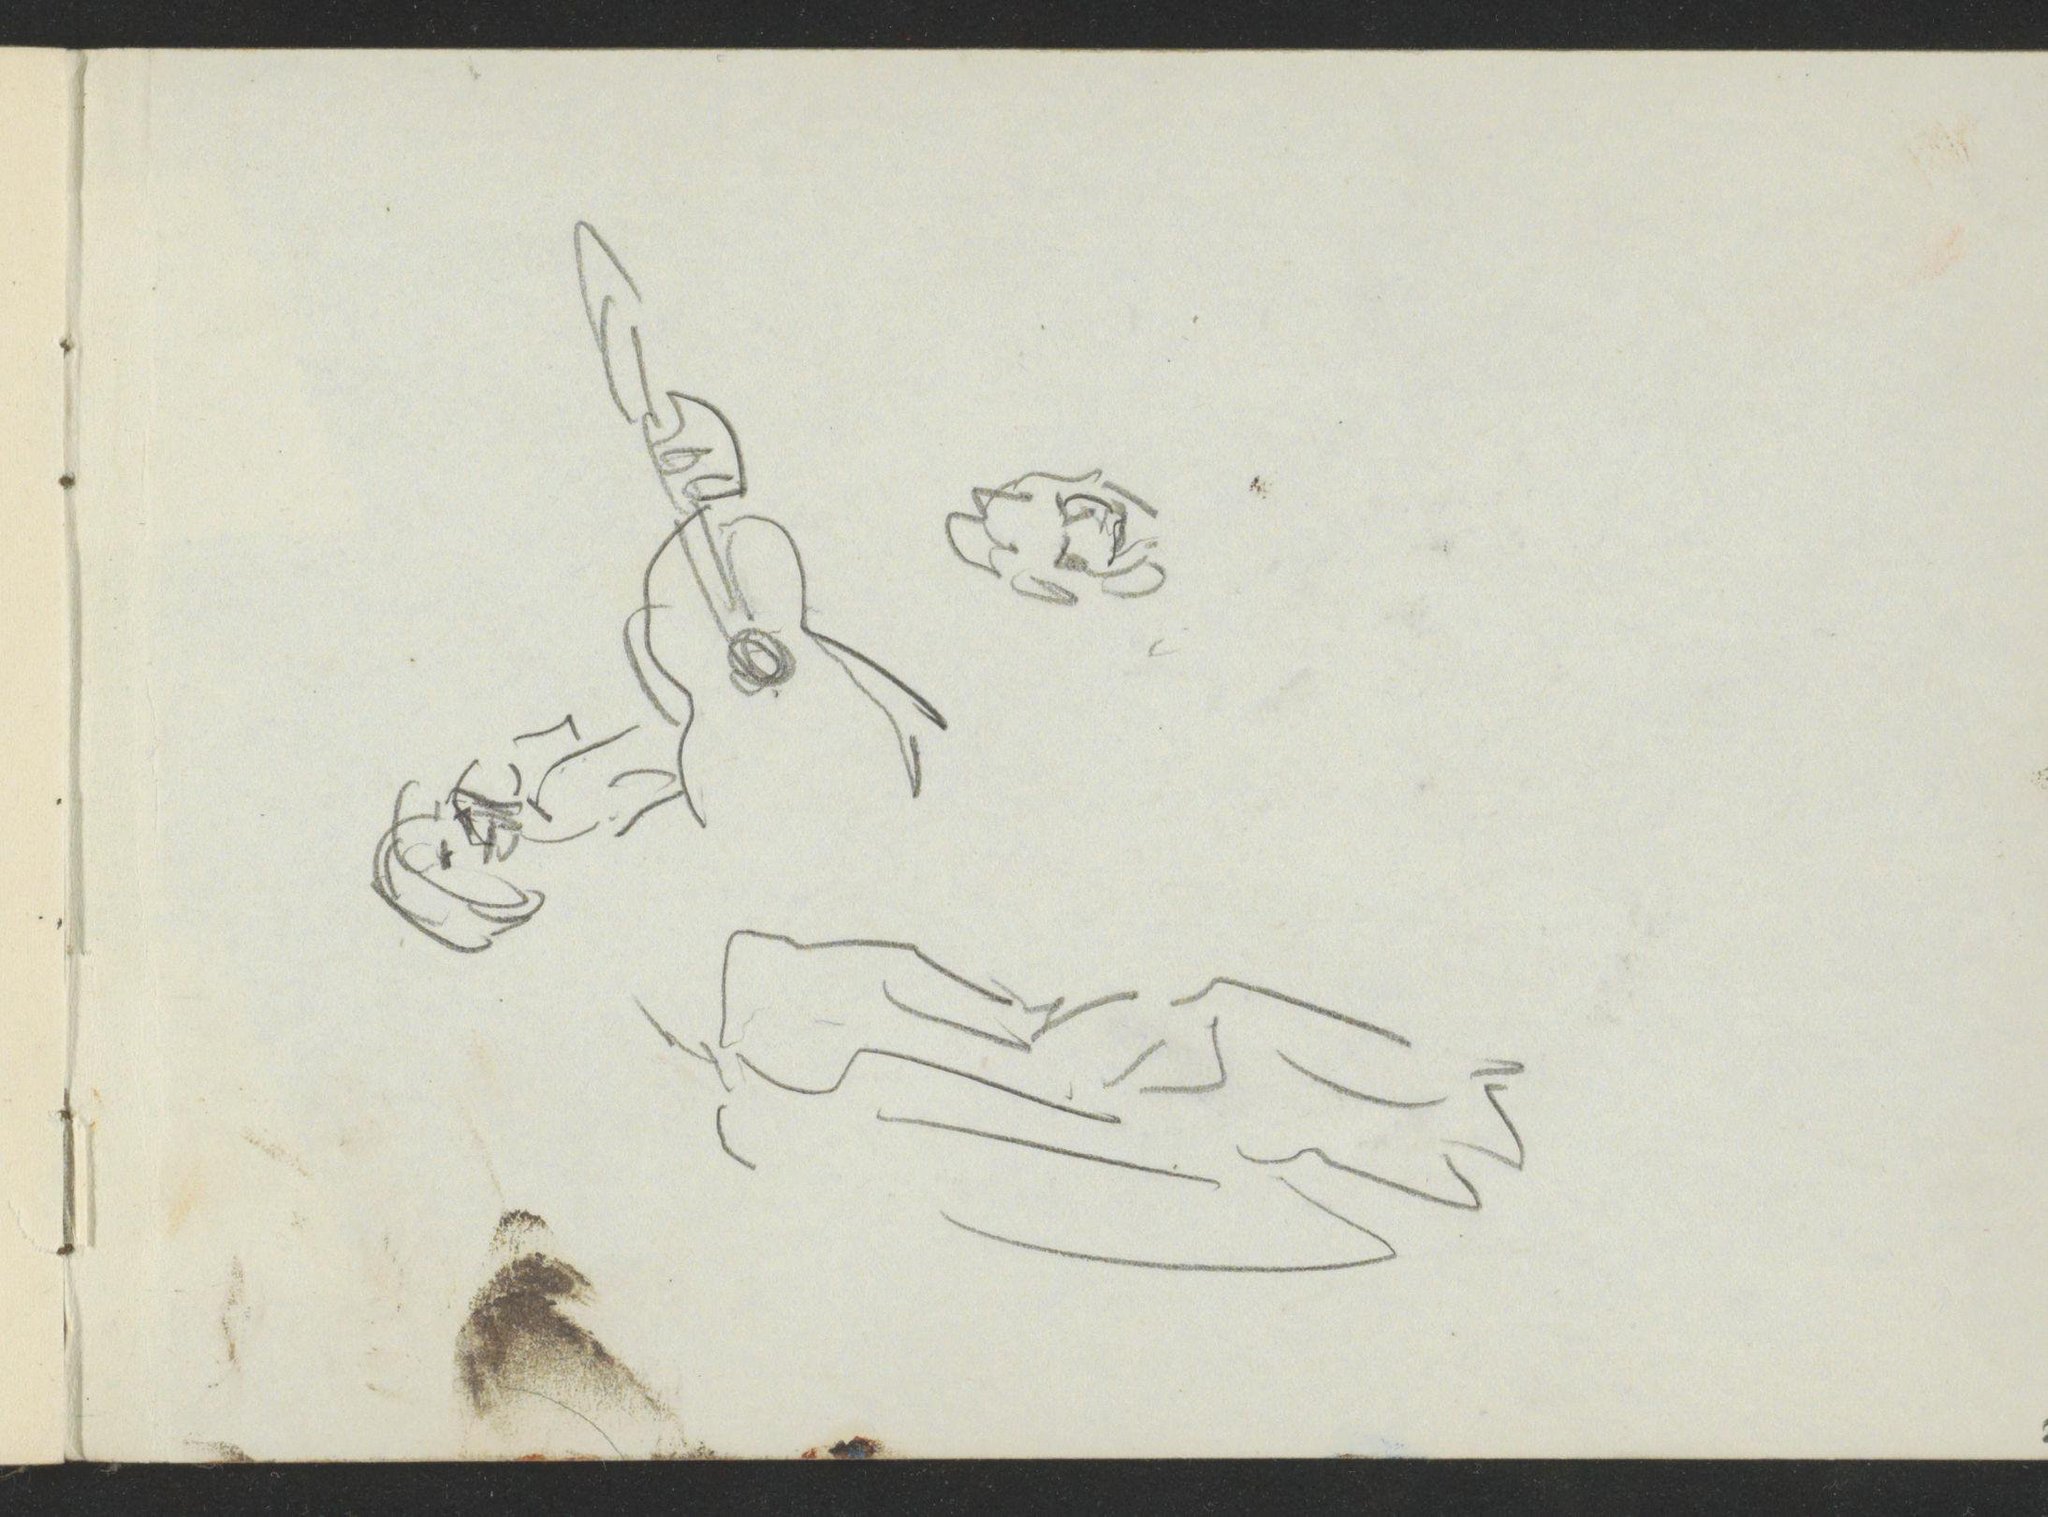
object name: endleaf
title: Gitaarspeler en een man in jacquet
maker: isaac israels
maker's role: draughtsman, painter, print maker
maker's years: 1865-1934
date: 1875-1934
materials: paper, pencil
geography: the hague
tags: adult man (+ standing), cithern, mandolin, guitar, balalaika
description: Schutblad B, achterste schutblad, uit schetsboek LXI met 20 bladen.